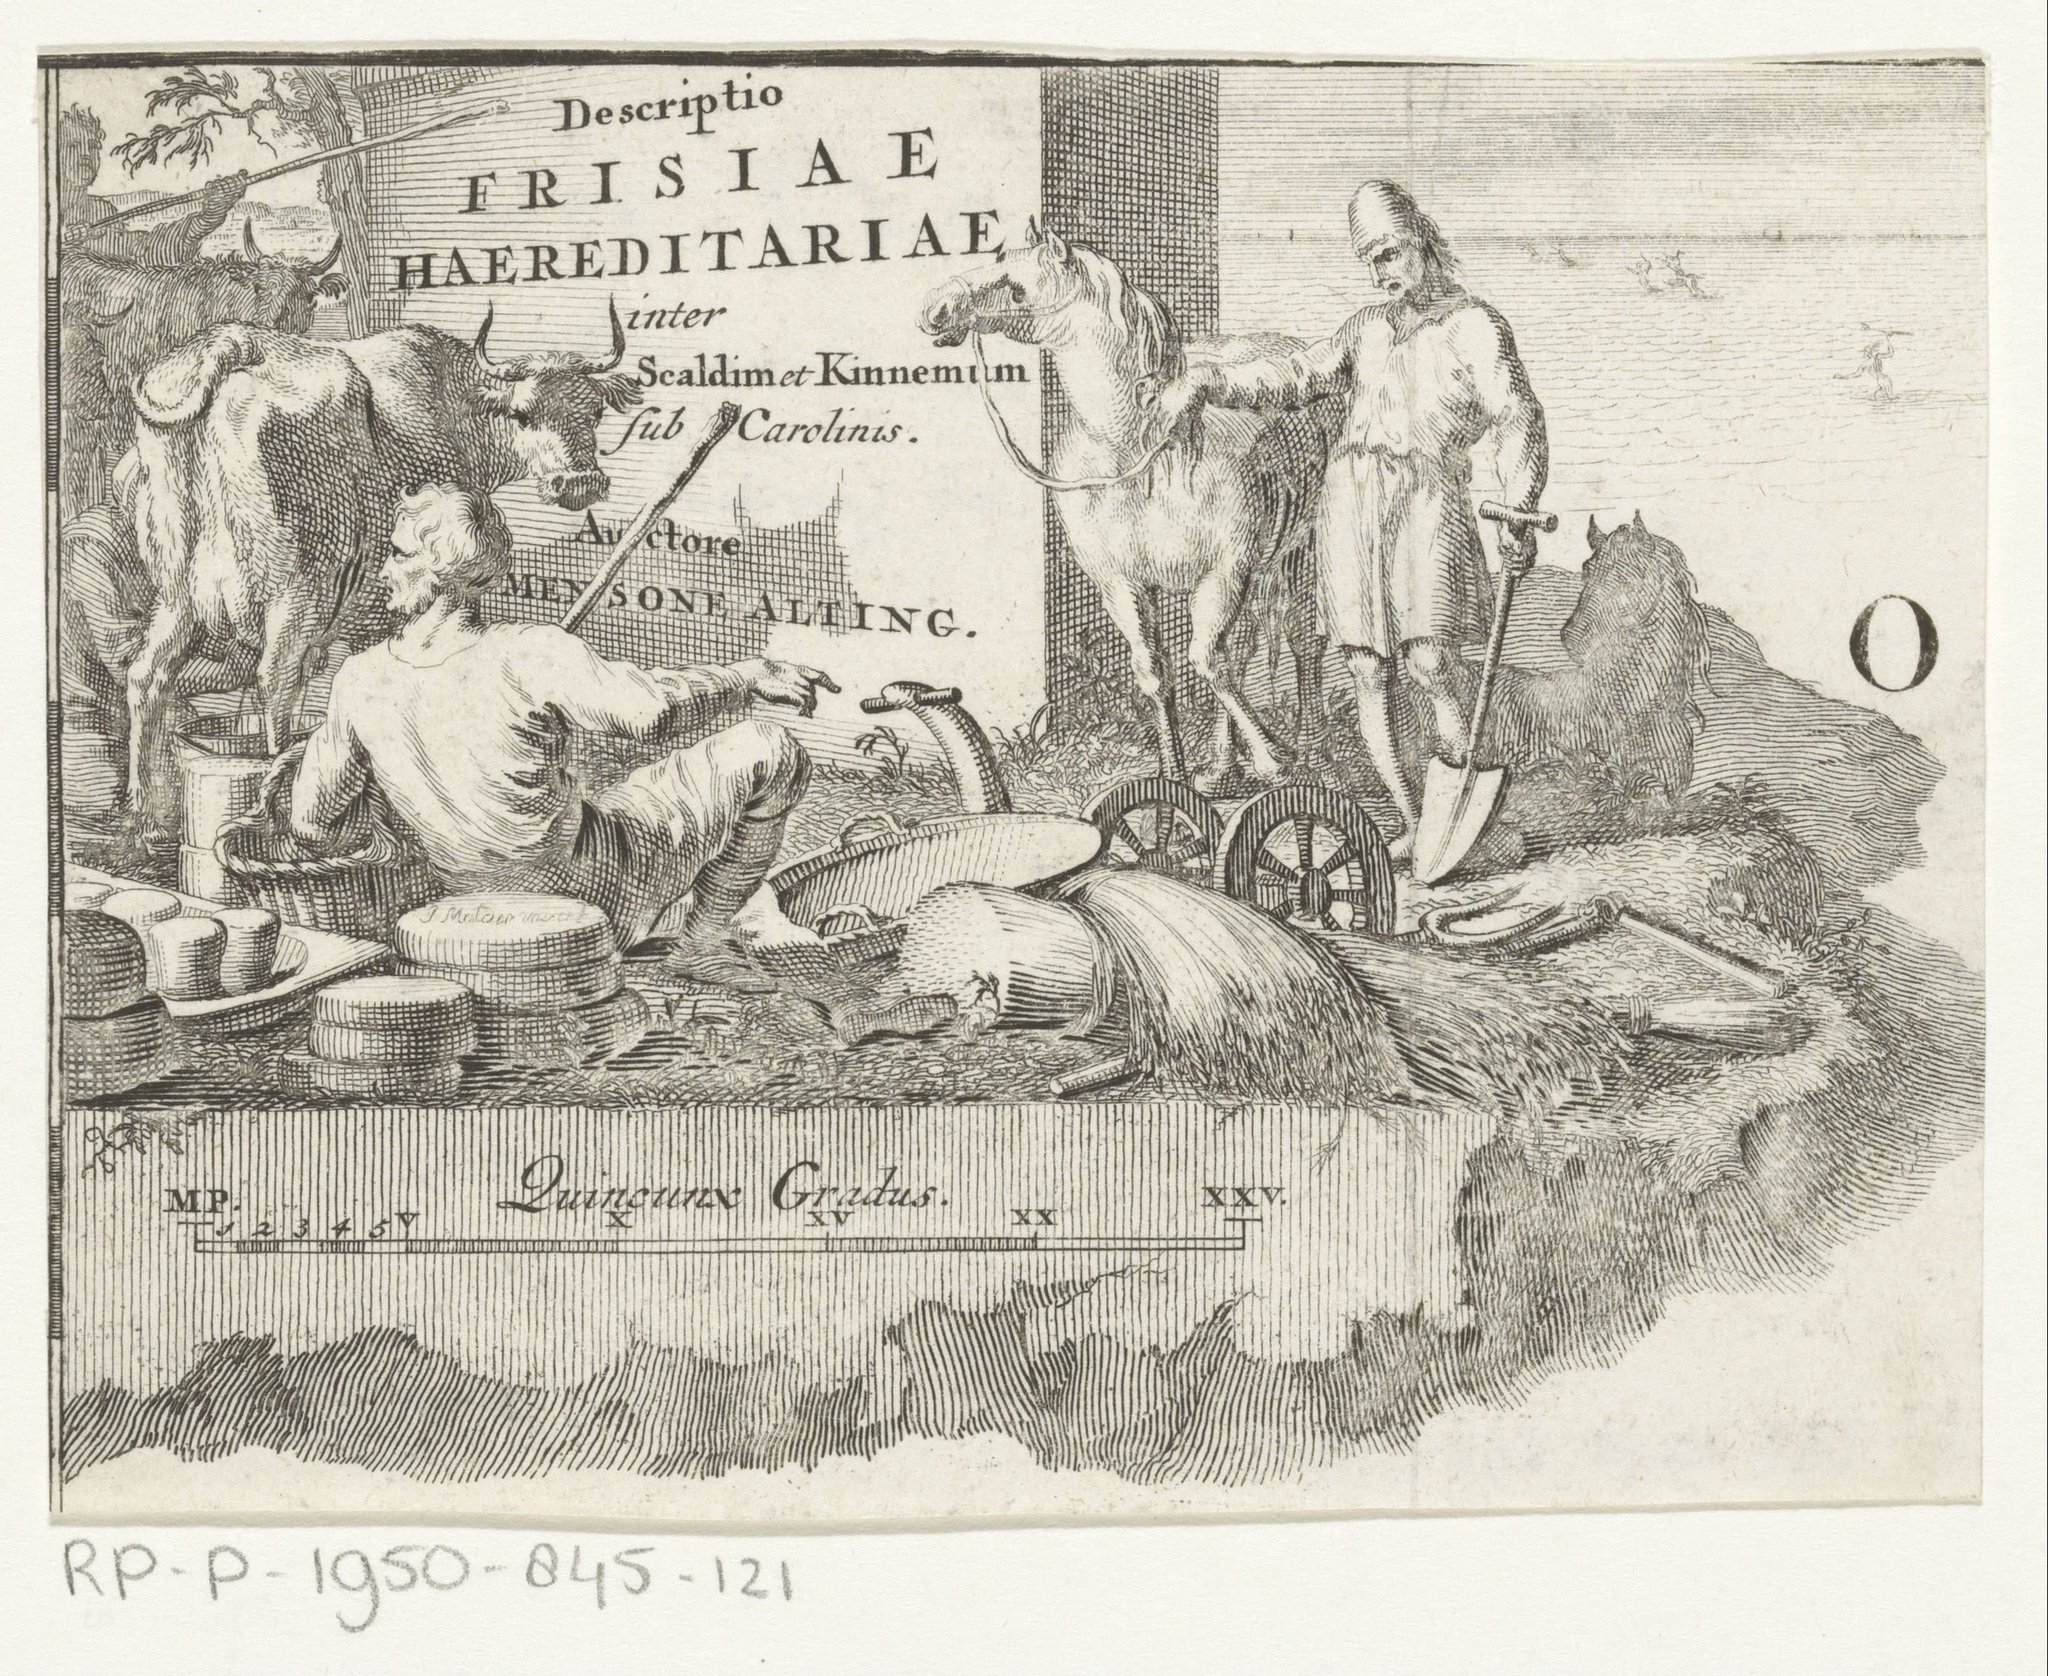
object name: print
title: Boeren met vee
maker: joseph mulder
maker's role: print maker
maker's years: 1658-1718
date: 1697-1700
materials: paper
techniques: engraving, etching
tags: cattle, farmers, netherlands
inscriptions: collector's mark: Lugt 2228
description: Maakt deel uit van 16 kaarten van het land van de Bataven en de Friezen eerst vervaardigd voor en opgenomen in Alting, Menso. Descriptio, secundum antiquos, agri Batavi & Frisii. 2 delen. Amsterdam: Henricus Wetstein, 1697-1700. Hergebruikt in Halma, François. Tooneel der Vereenigde Nederlanden, en onderhorige landschappen (...). 2 delen. Leeuwarden: Hendrik Halma, 1725. Prent afkomstig uit een plakalbum met titelprenten, ornamenten etc. op blauw papier in 1983 uit elkaar gehaald. Volgens een notitie op verso zat de prent op p. 121 van dit album.